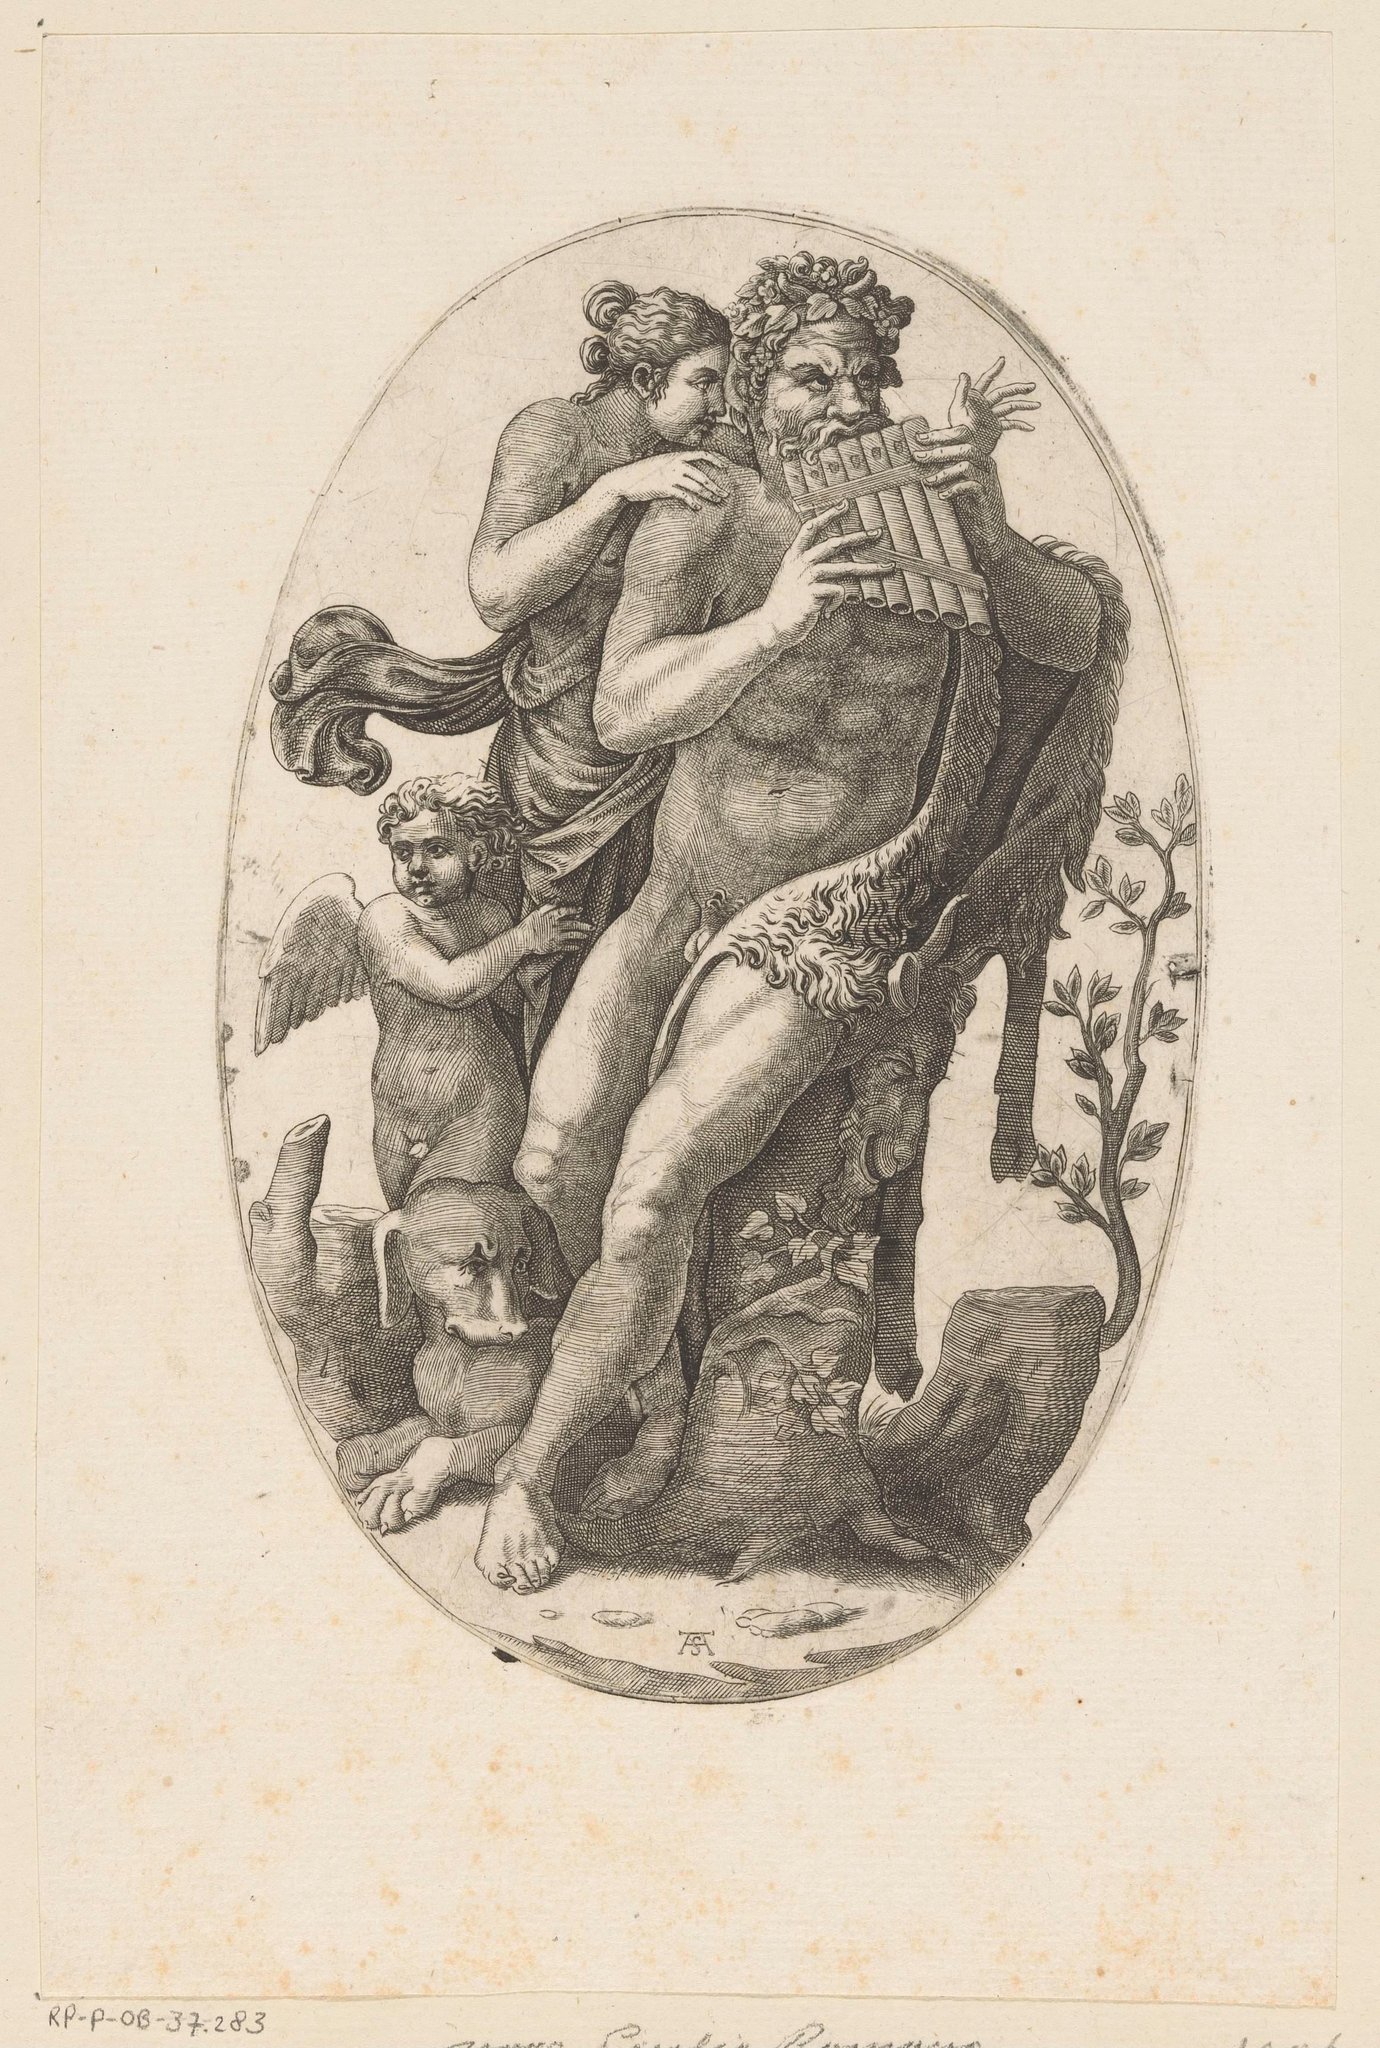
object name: print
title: Sater met panfluit en een nimf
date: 1540-1585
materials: paper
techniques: engraving, intaglio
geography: italy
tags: panpipes, satyrs, fauns, sileni, nymphs (in general); 'ninfe in commune' (ripa), cupids: 'amores', 'amoretti', 'putti'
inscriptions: collector's mark: Lugt 240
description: Een sater spelend op een panfluit. Naast hem staan een nimf en een putto. Aan zijn voeten ligt een hond.